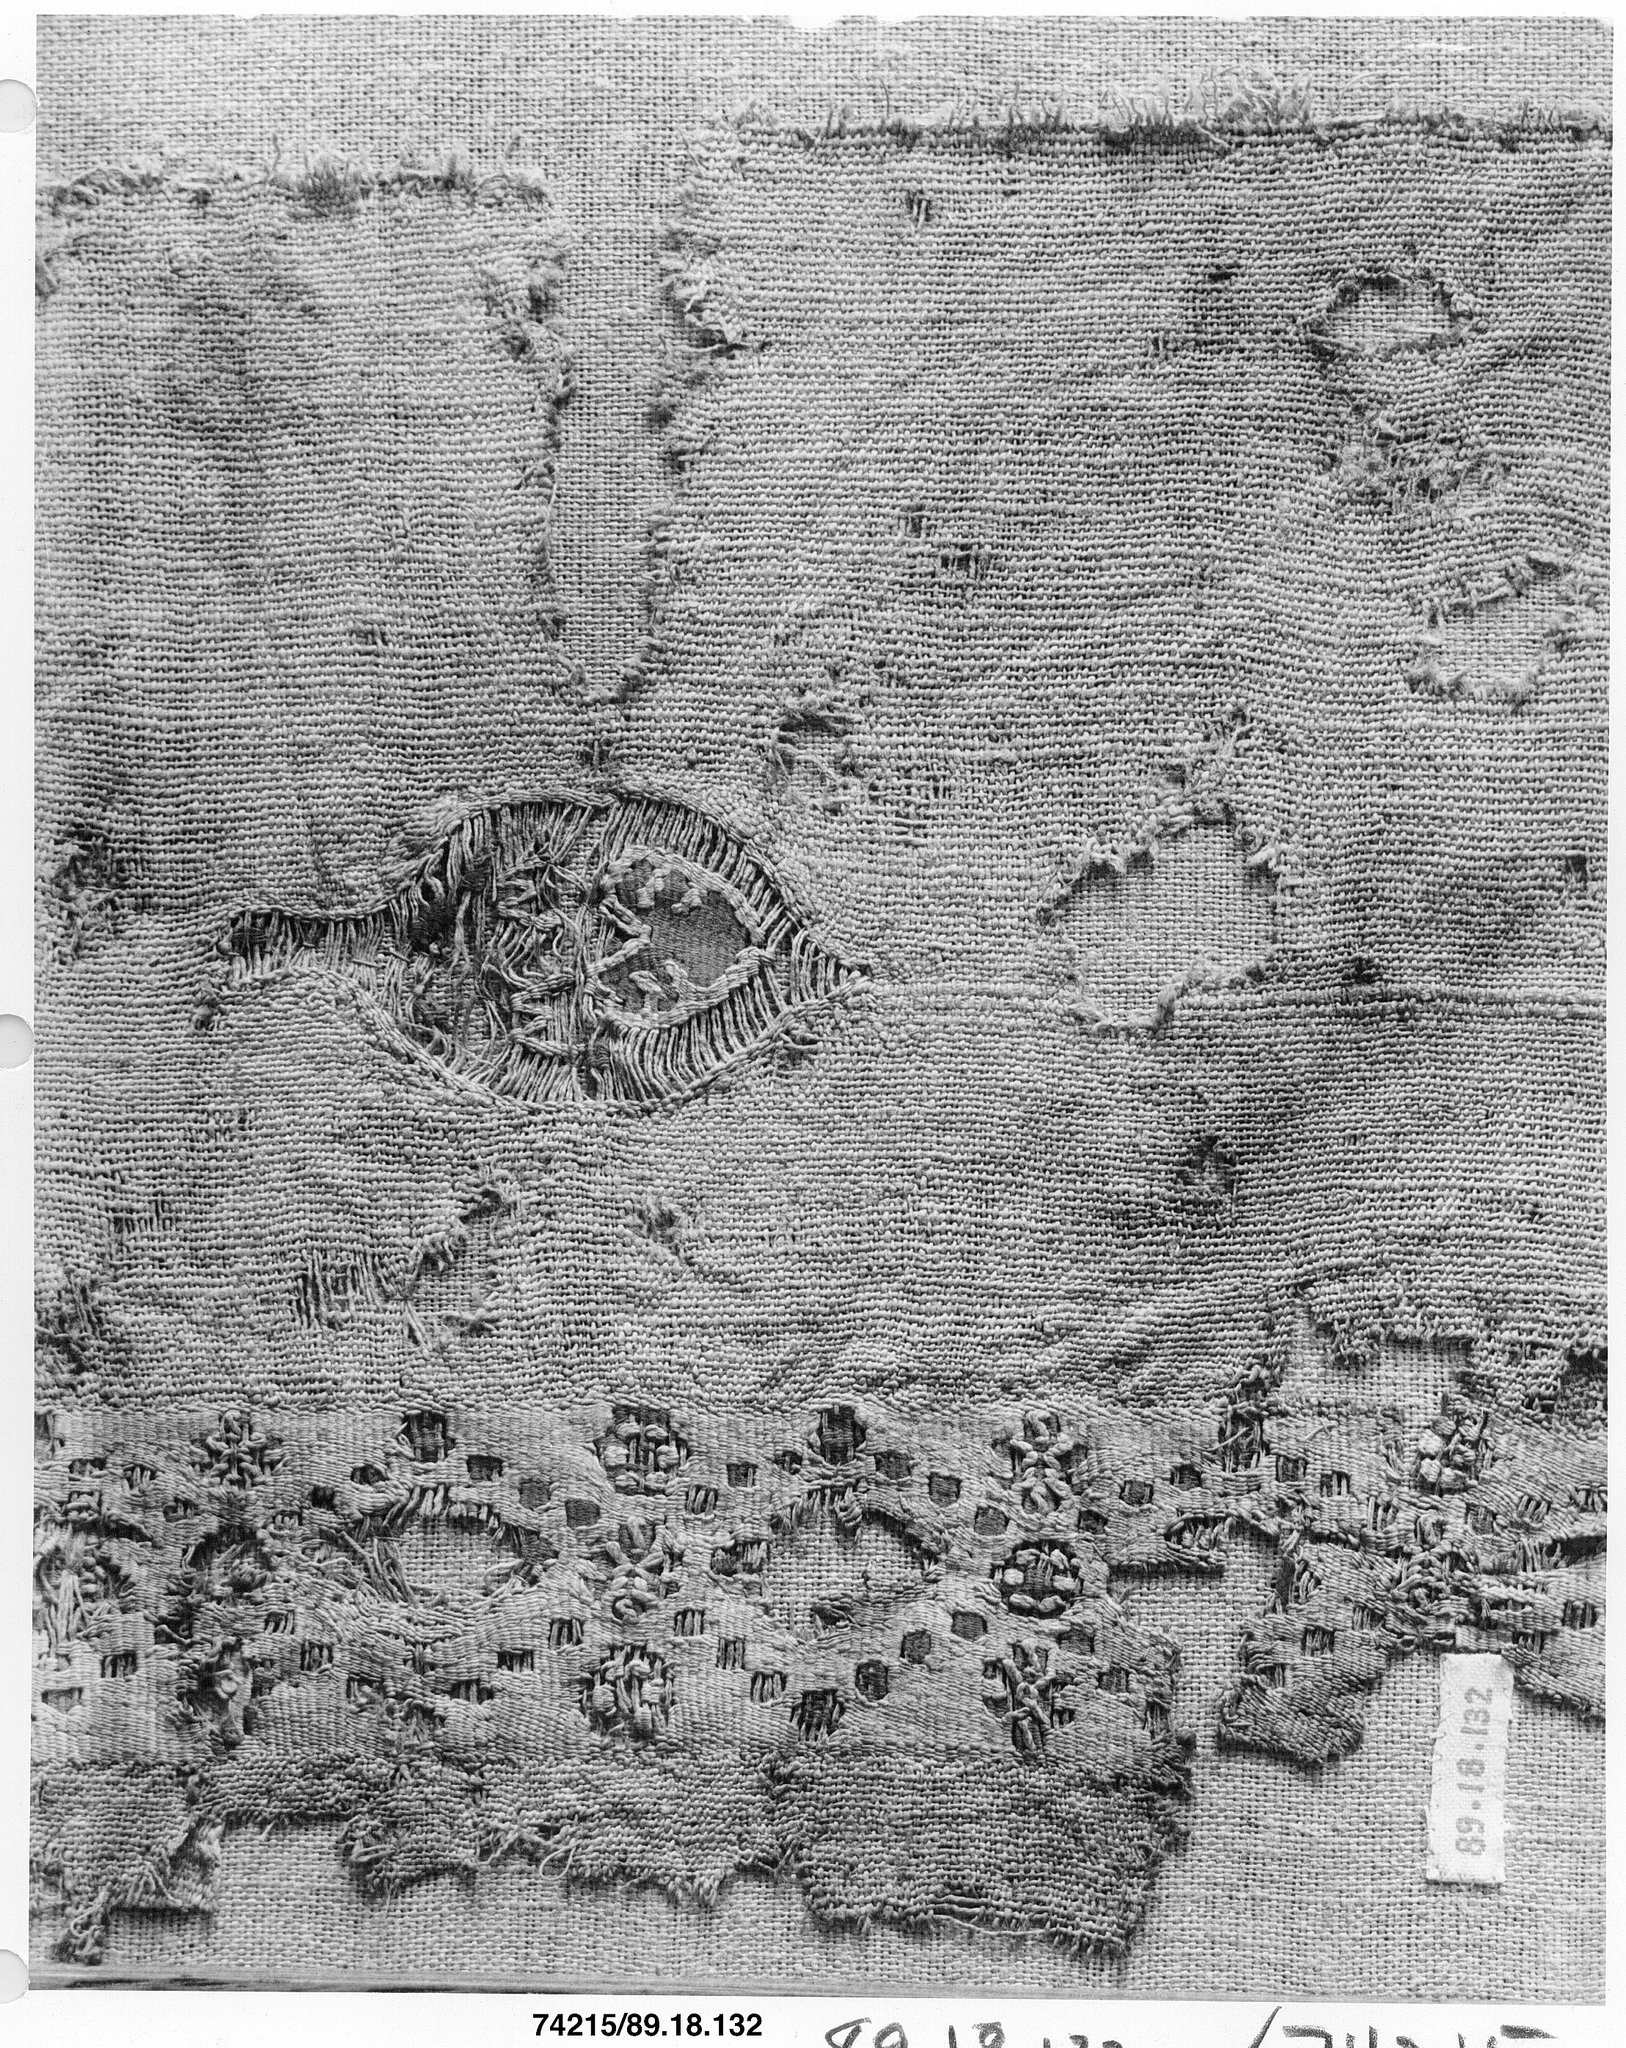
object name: textile fragment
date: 401-600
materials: linen, wool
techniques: weave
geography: egypt